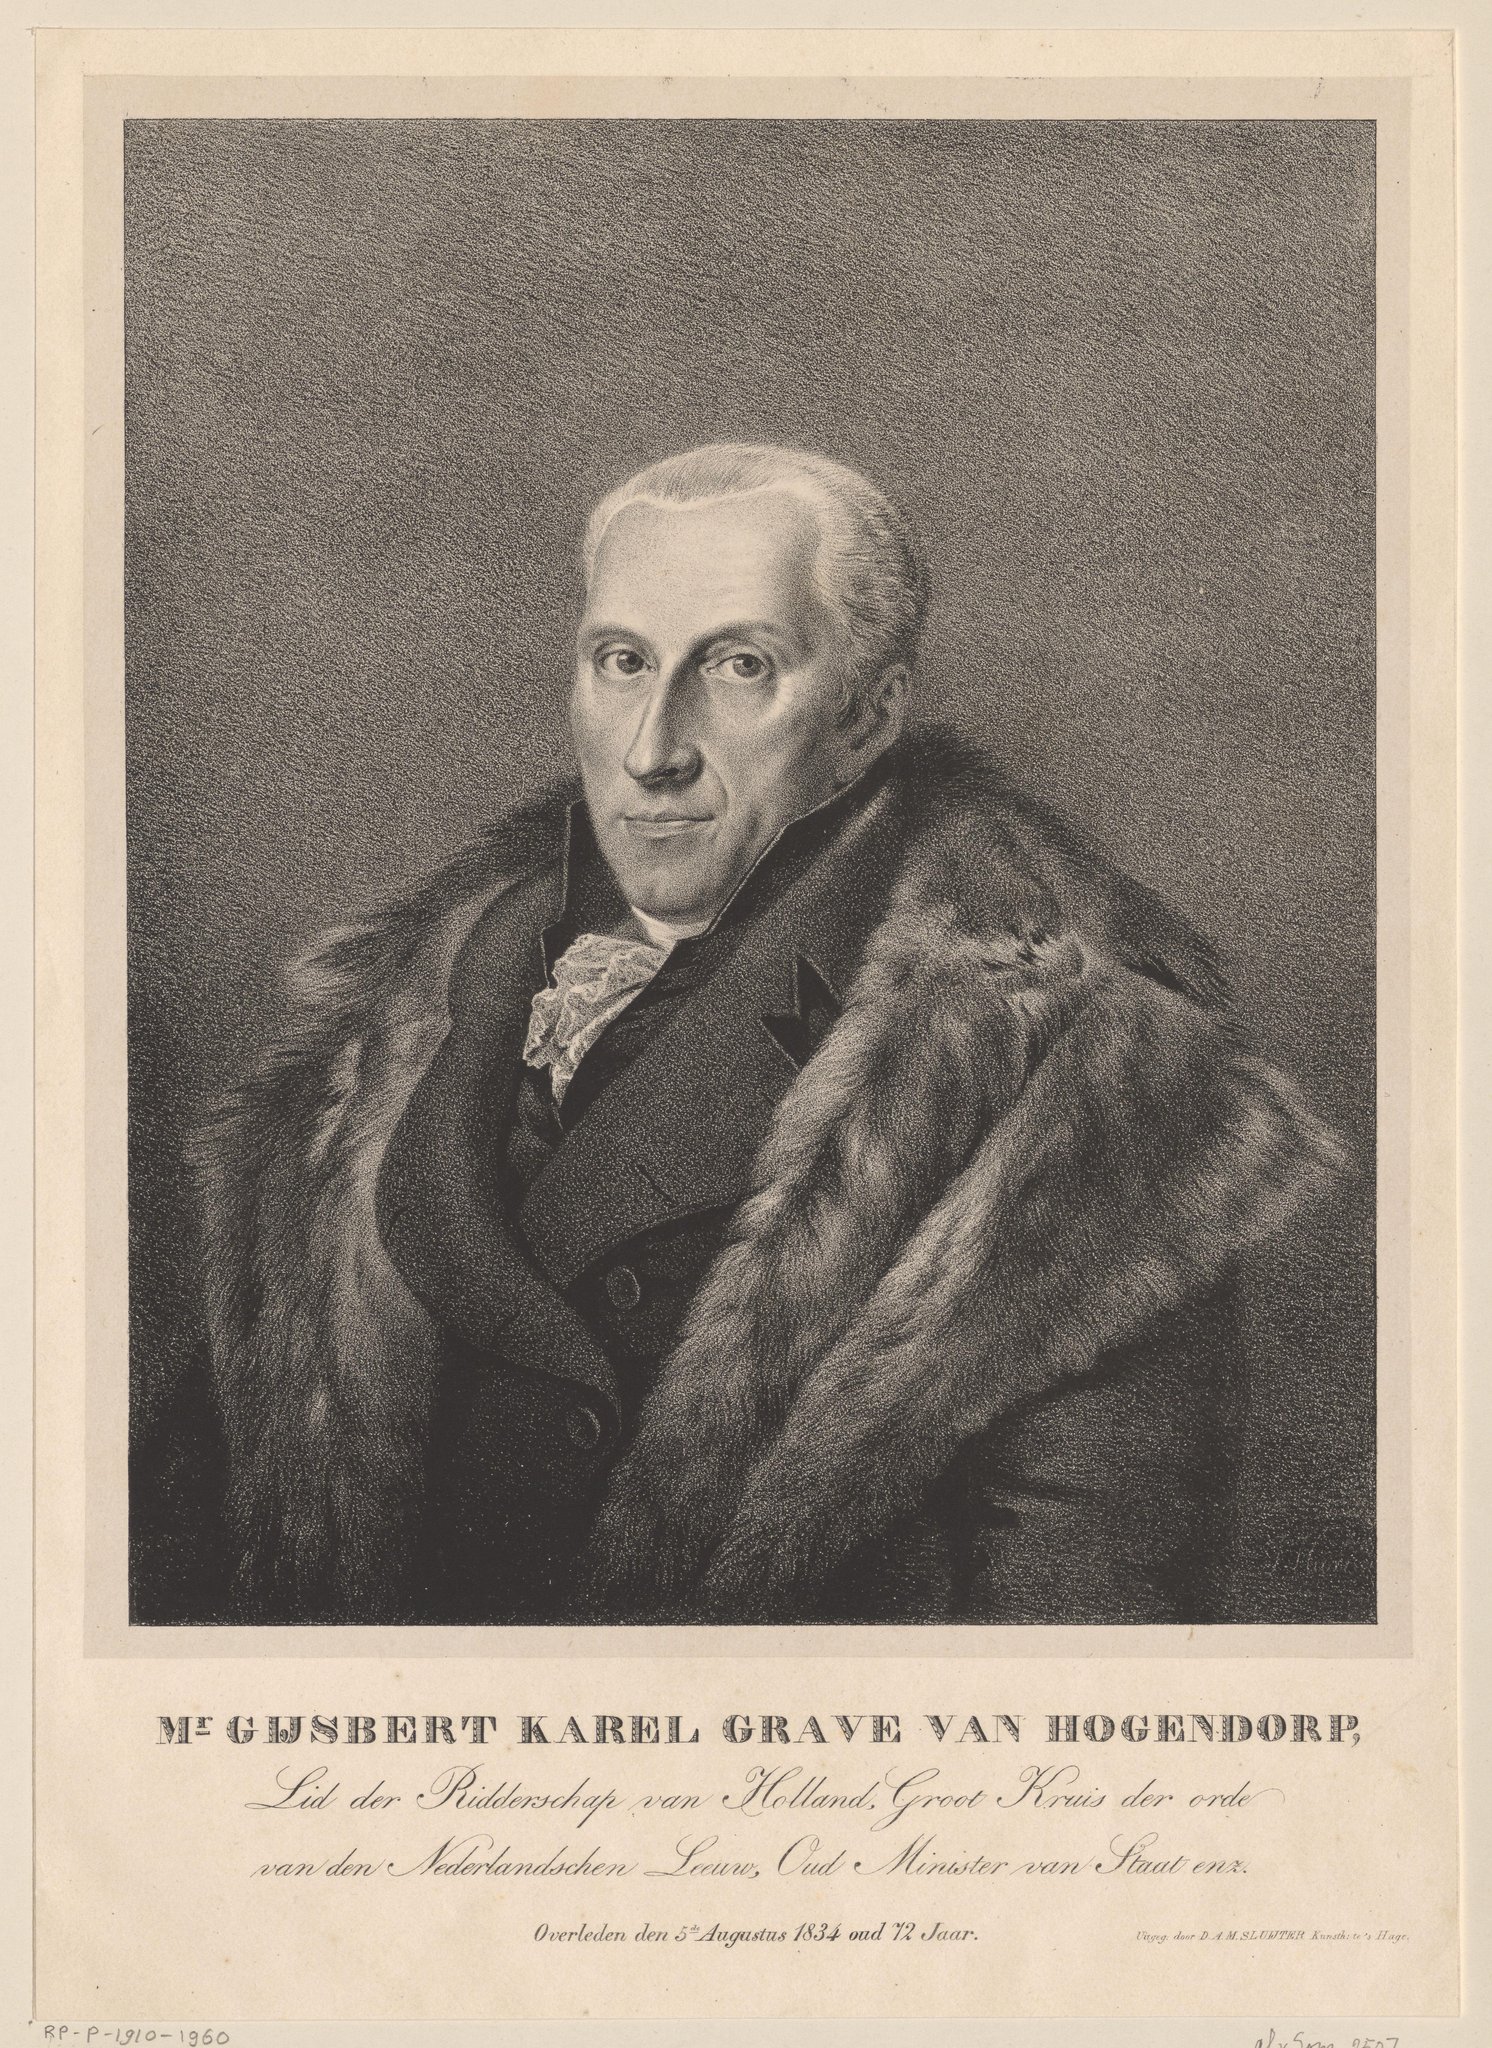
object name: print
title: Portret van Gijsbert Karel van Hogendorp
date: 1834-1836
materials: paper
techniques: lithograph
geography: the hague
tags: rotterdam, the hague, gijsbert karel graaf van hogendorp, historical persons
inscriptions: collector's mark: Lugt 2228